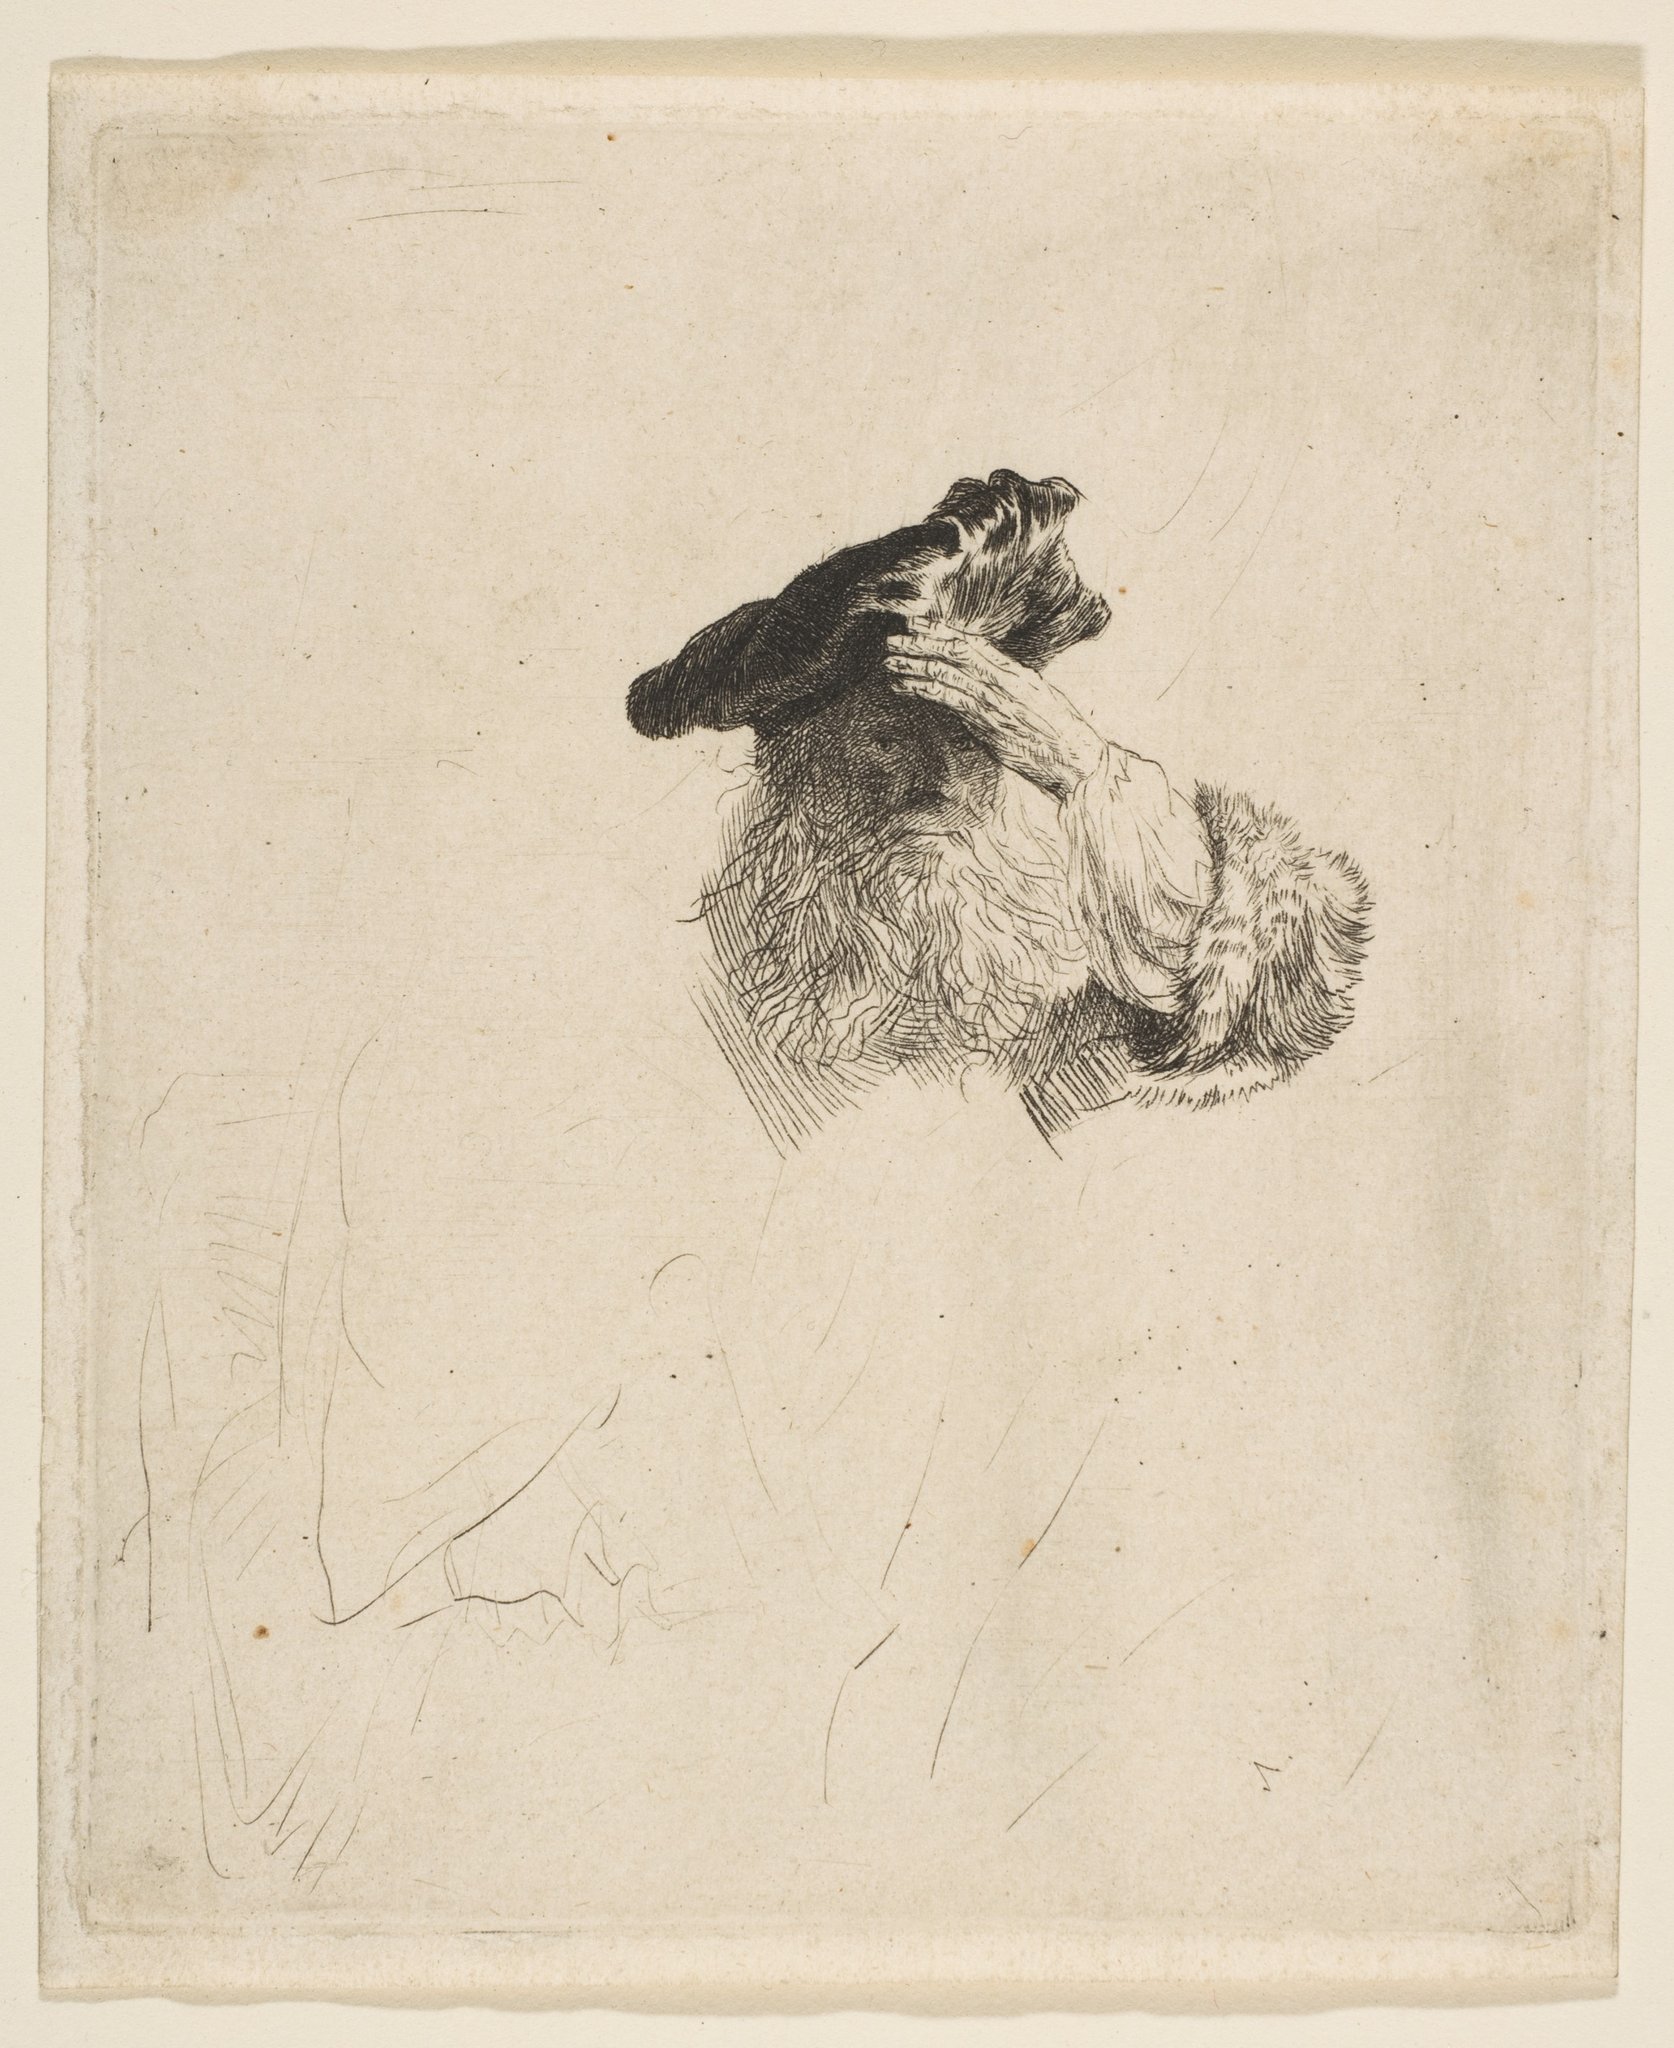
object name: print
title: Old Man Shading His Eyes with His Hand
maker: rembrandt van rijn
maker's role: artist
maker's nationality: dutch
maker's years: 1606-1669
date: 1639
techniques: drypoint, etching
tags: men,portraits